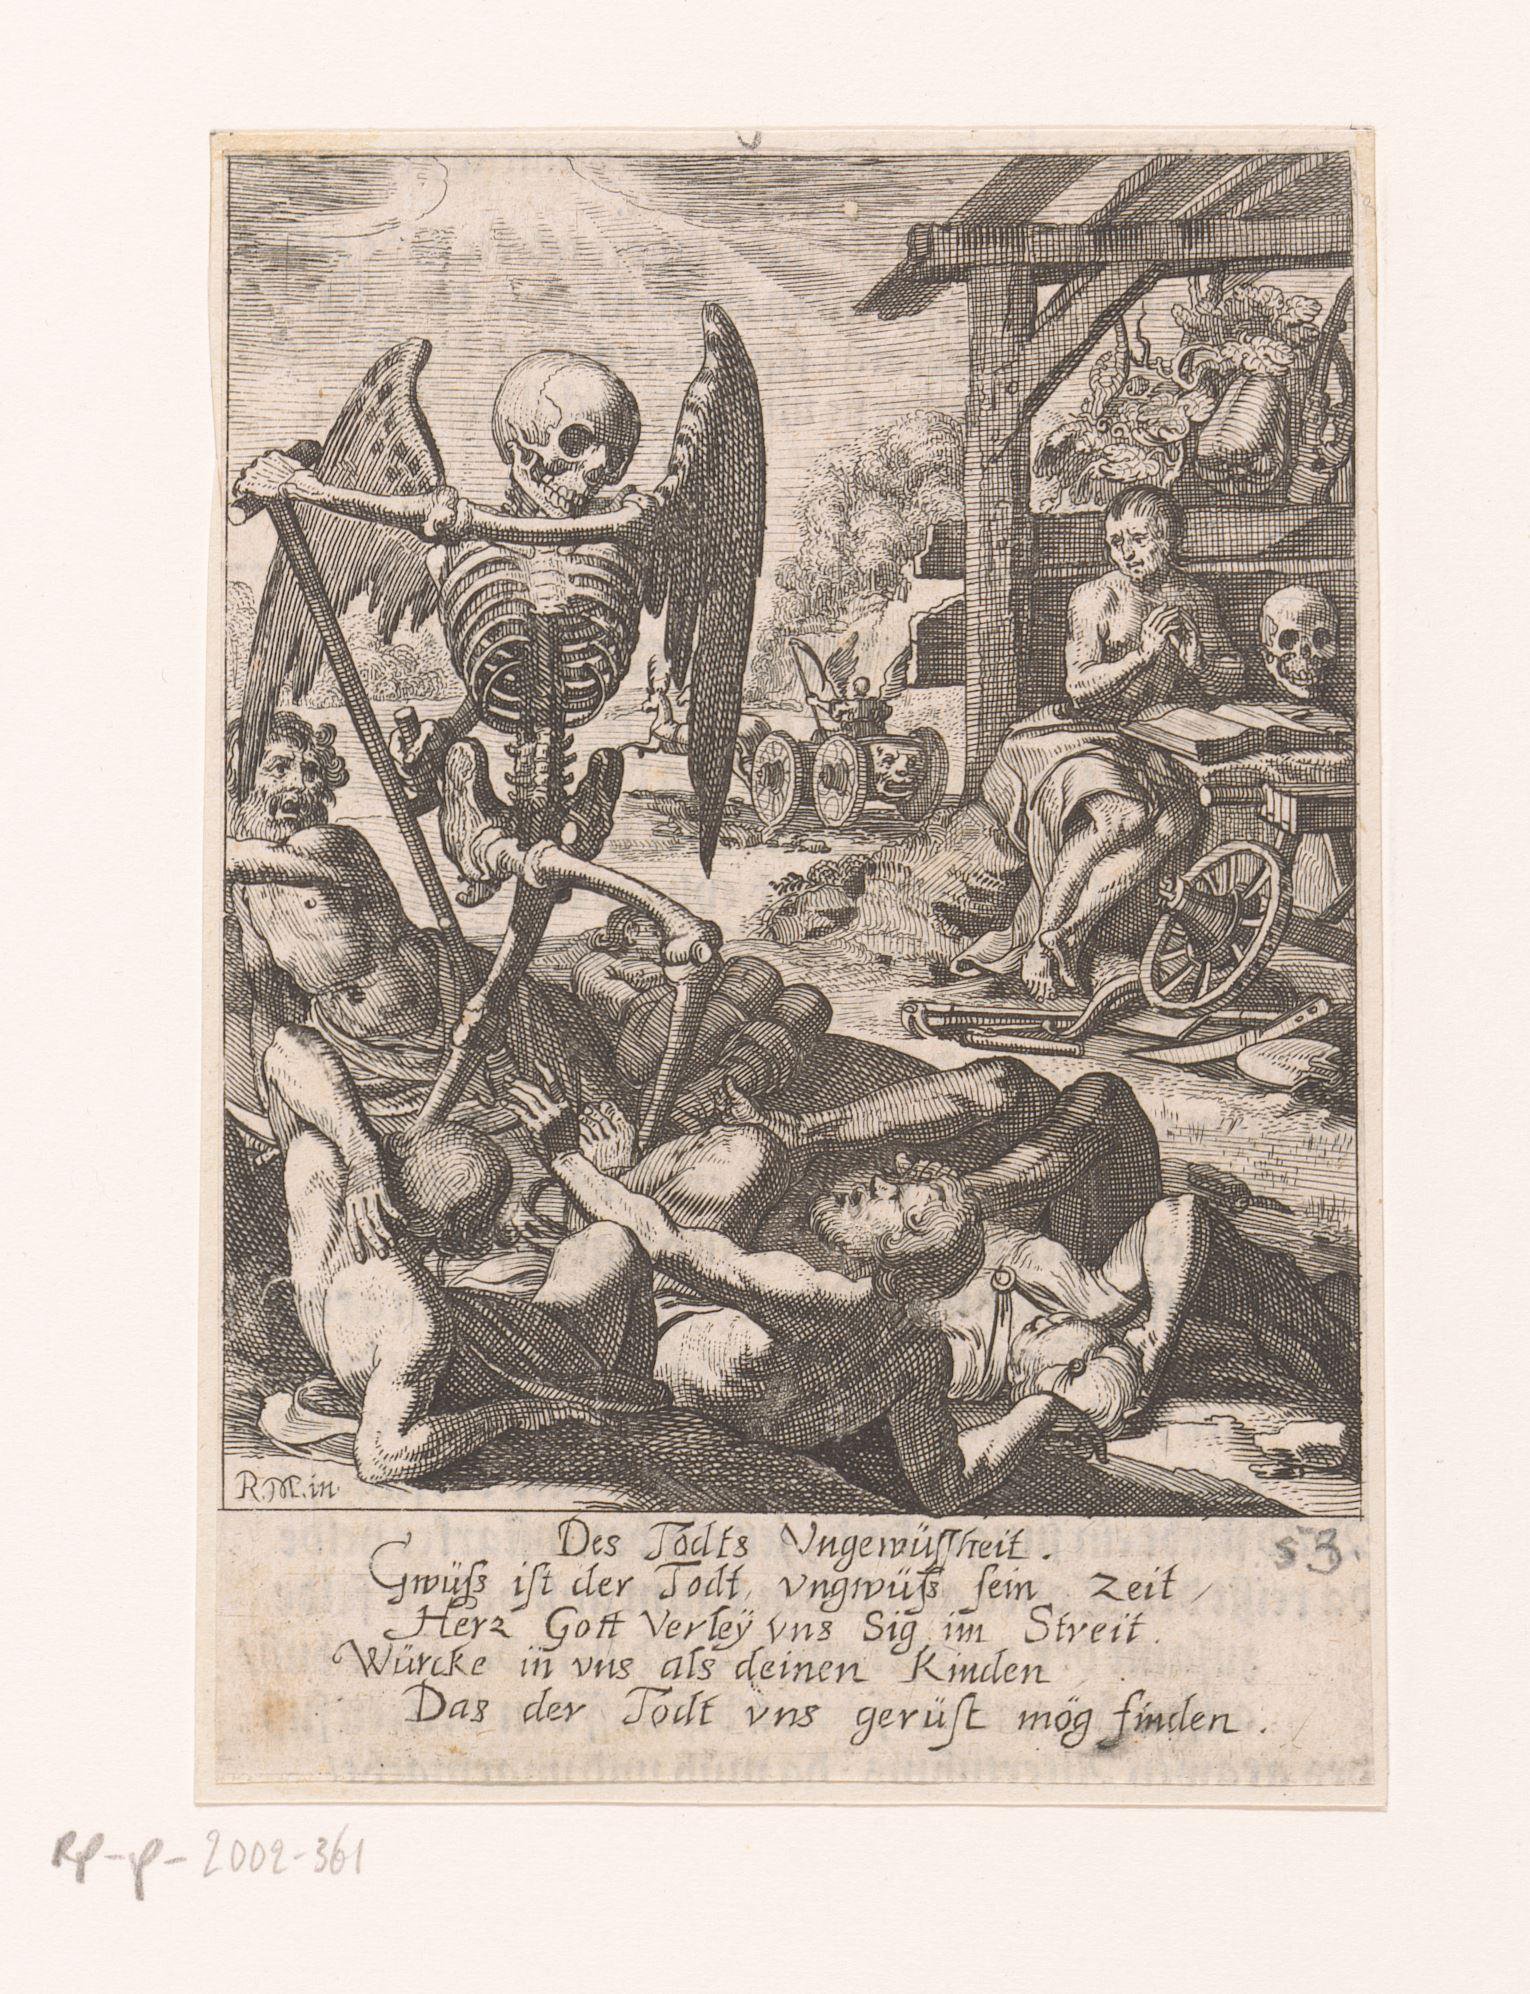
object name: print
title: De Dodendans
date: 1650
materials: paper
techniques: etching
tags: personifications of death; 'morte' (ripa), dance of death; death together with one or more human beings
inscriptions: collector's mark: Lugt 2233, collector's mark: Lugt 2228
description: Prent uit: Meyer, Rudolph. Sterbenspiegel, das ist sonnenklare Vorstellung menschlicher Nichtigkeit durch alle Ständ und Geschlechter (...). Zürich: J.J. Bodmer, 1650.